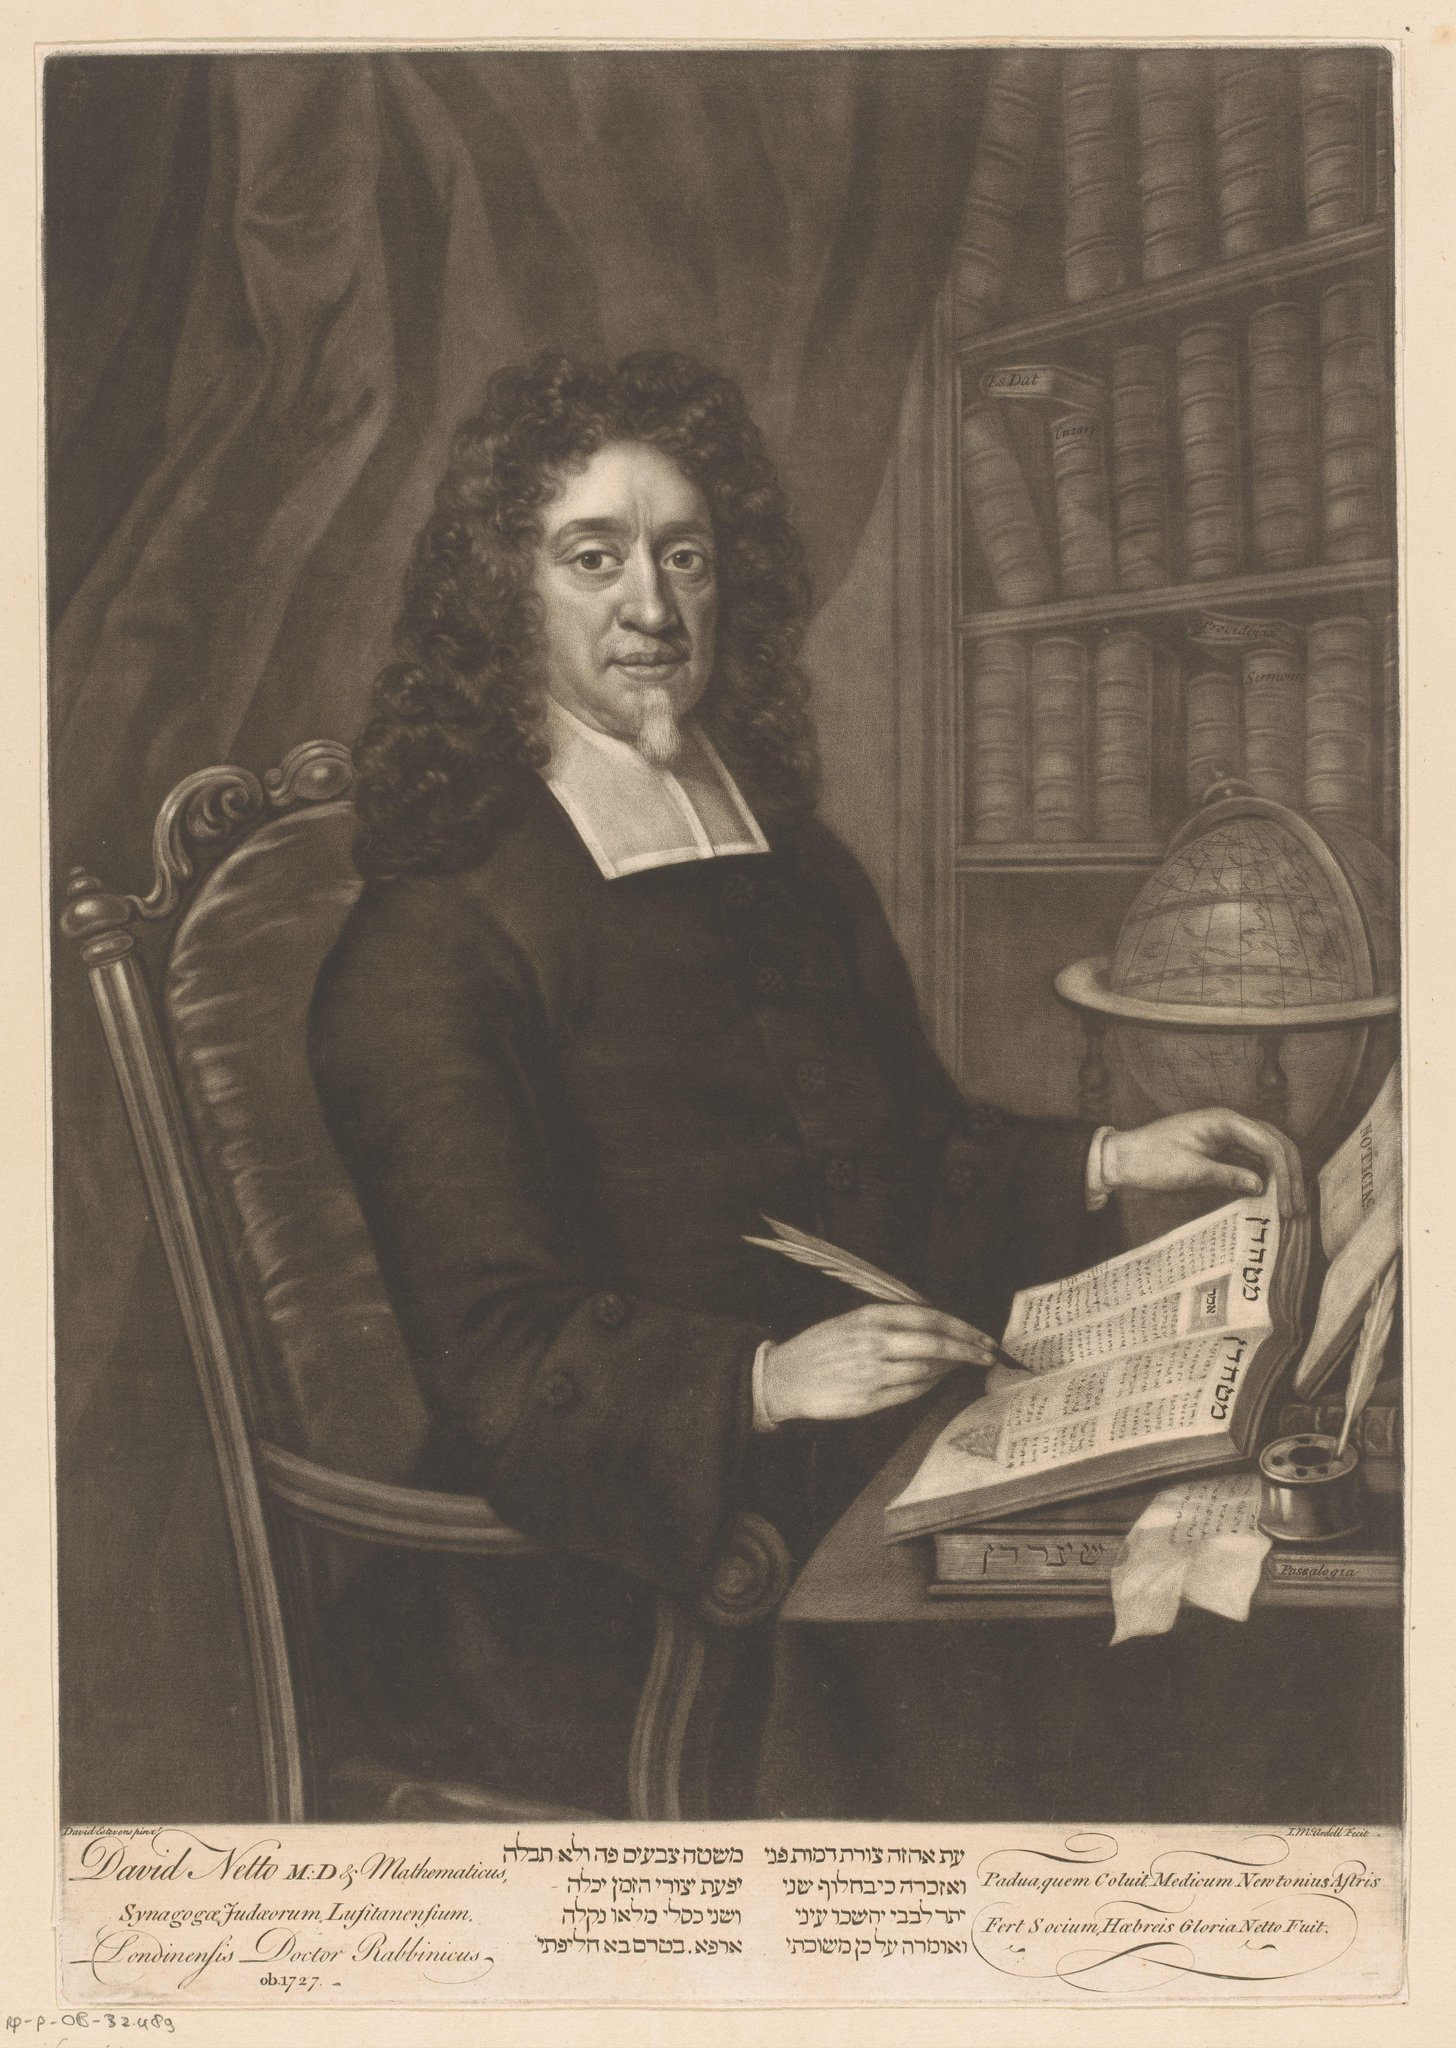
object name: print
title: David Netto M:D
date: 1745-1765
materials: paper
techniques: mezzotint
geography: london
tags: venice, handwriting, writing as activity, historical persons, physician, doctor (+ portrait of scholar, scientist), globe, rabbi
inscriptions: collector's mark: Lugt 240